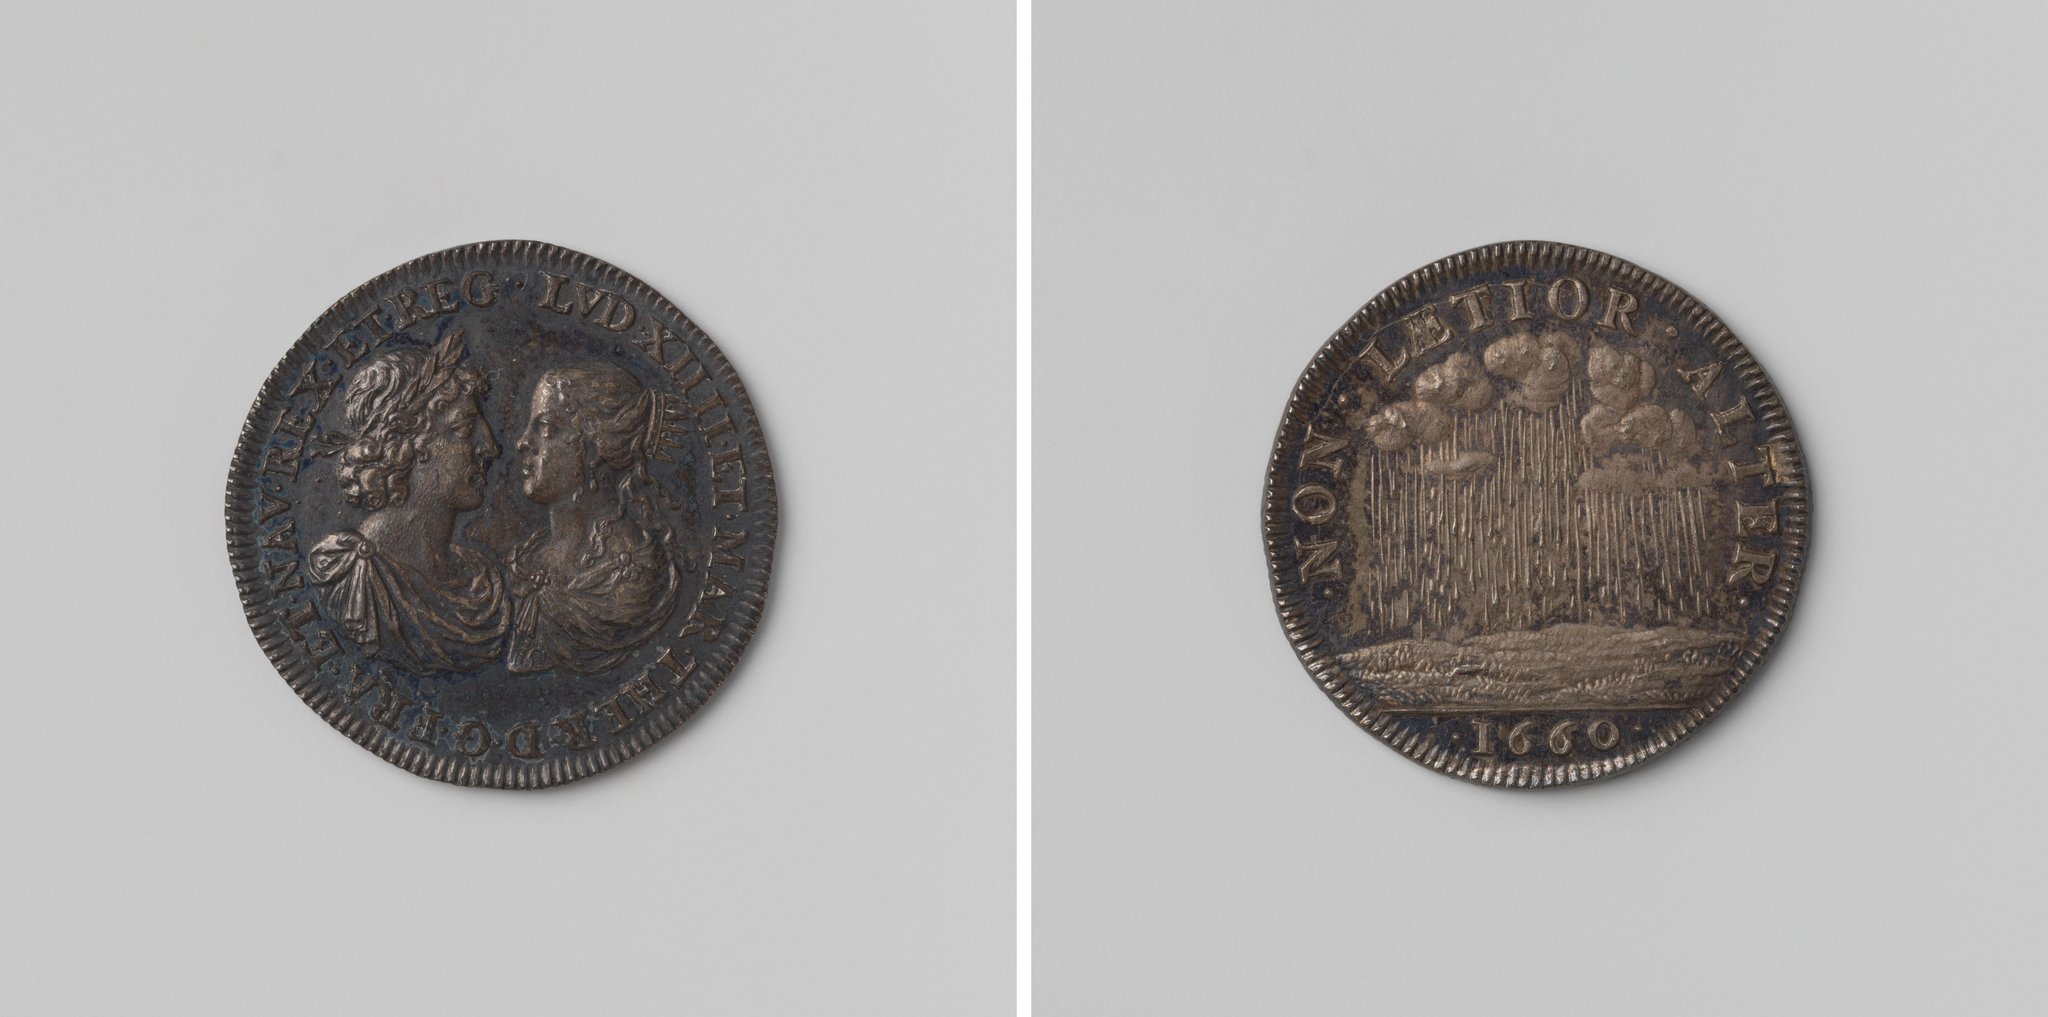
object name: strooipenning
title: Huwelijk van Lodewijk XIV en Maria Theresia, koning en koningin van Frankrijk, penning uitgestrooid onder de aanwezigen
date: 1660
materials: silver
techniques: striking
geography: paris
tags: lodewijk xiv (koning van frankrijk), maria theresia (koningin van frankrijk)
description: Zilveren penning. Voorzijde: naar elkaar gewende borststukken van man met lauwerkrans en vrouw met kroon binnen omschrift. Keerzijde: uit wolken vallende regen binnen omschrift; afsnede: jaartal